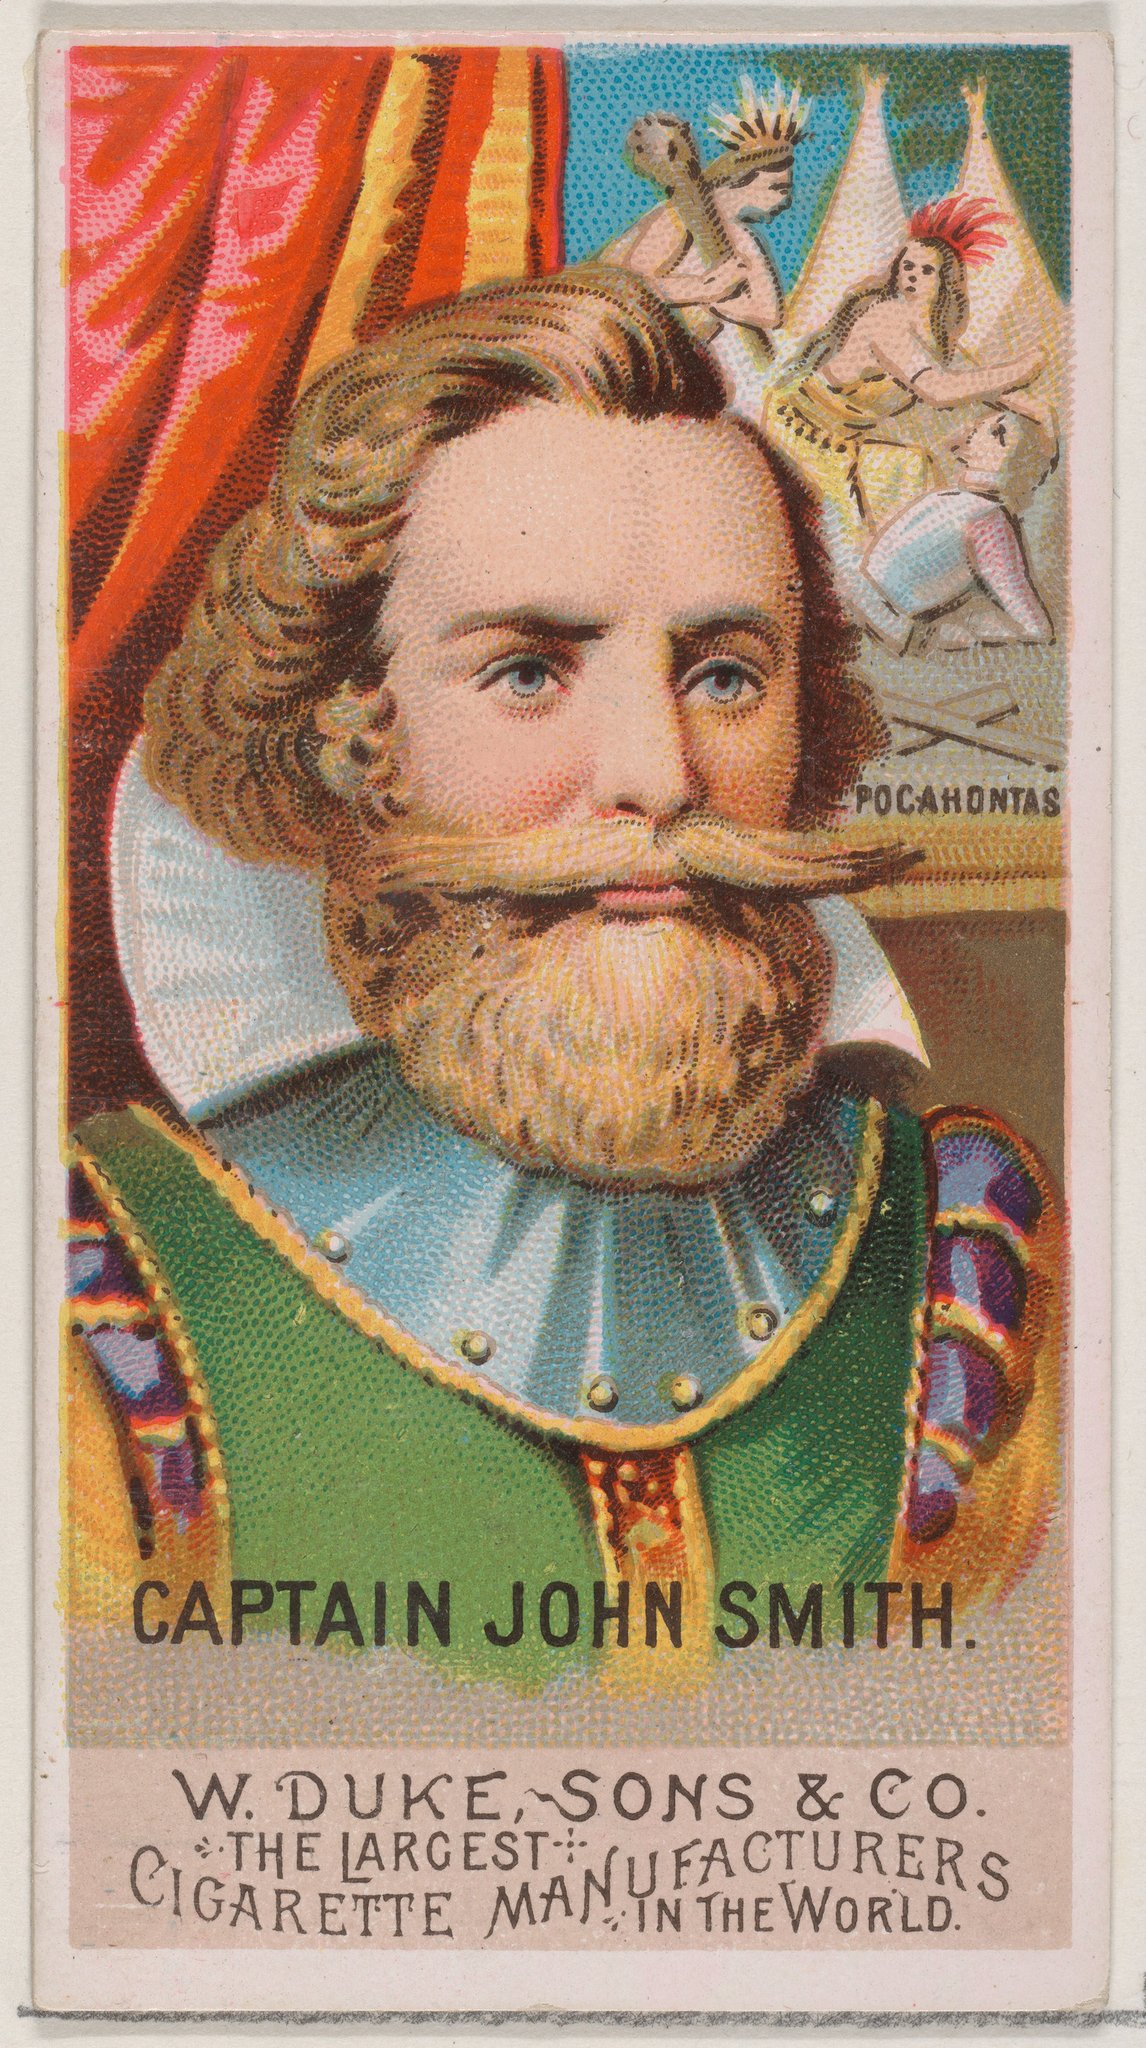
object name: print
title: Captain John Smith, from the series Great Americans (N76) for Duke brand cigarettes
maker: w. duke, sons & co.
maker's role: publisher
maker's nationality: american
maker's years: 1870-1920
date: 1888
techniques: color lithograph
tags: men